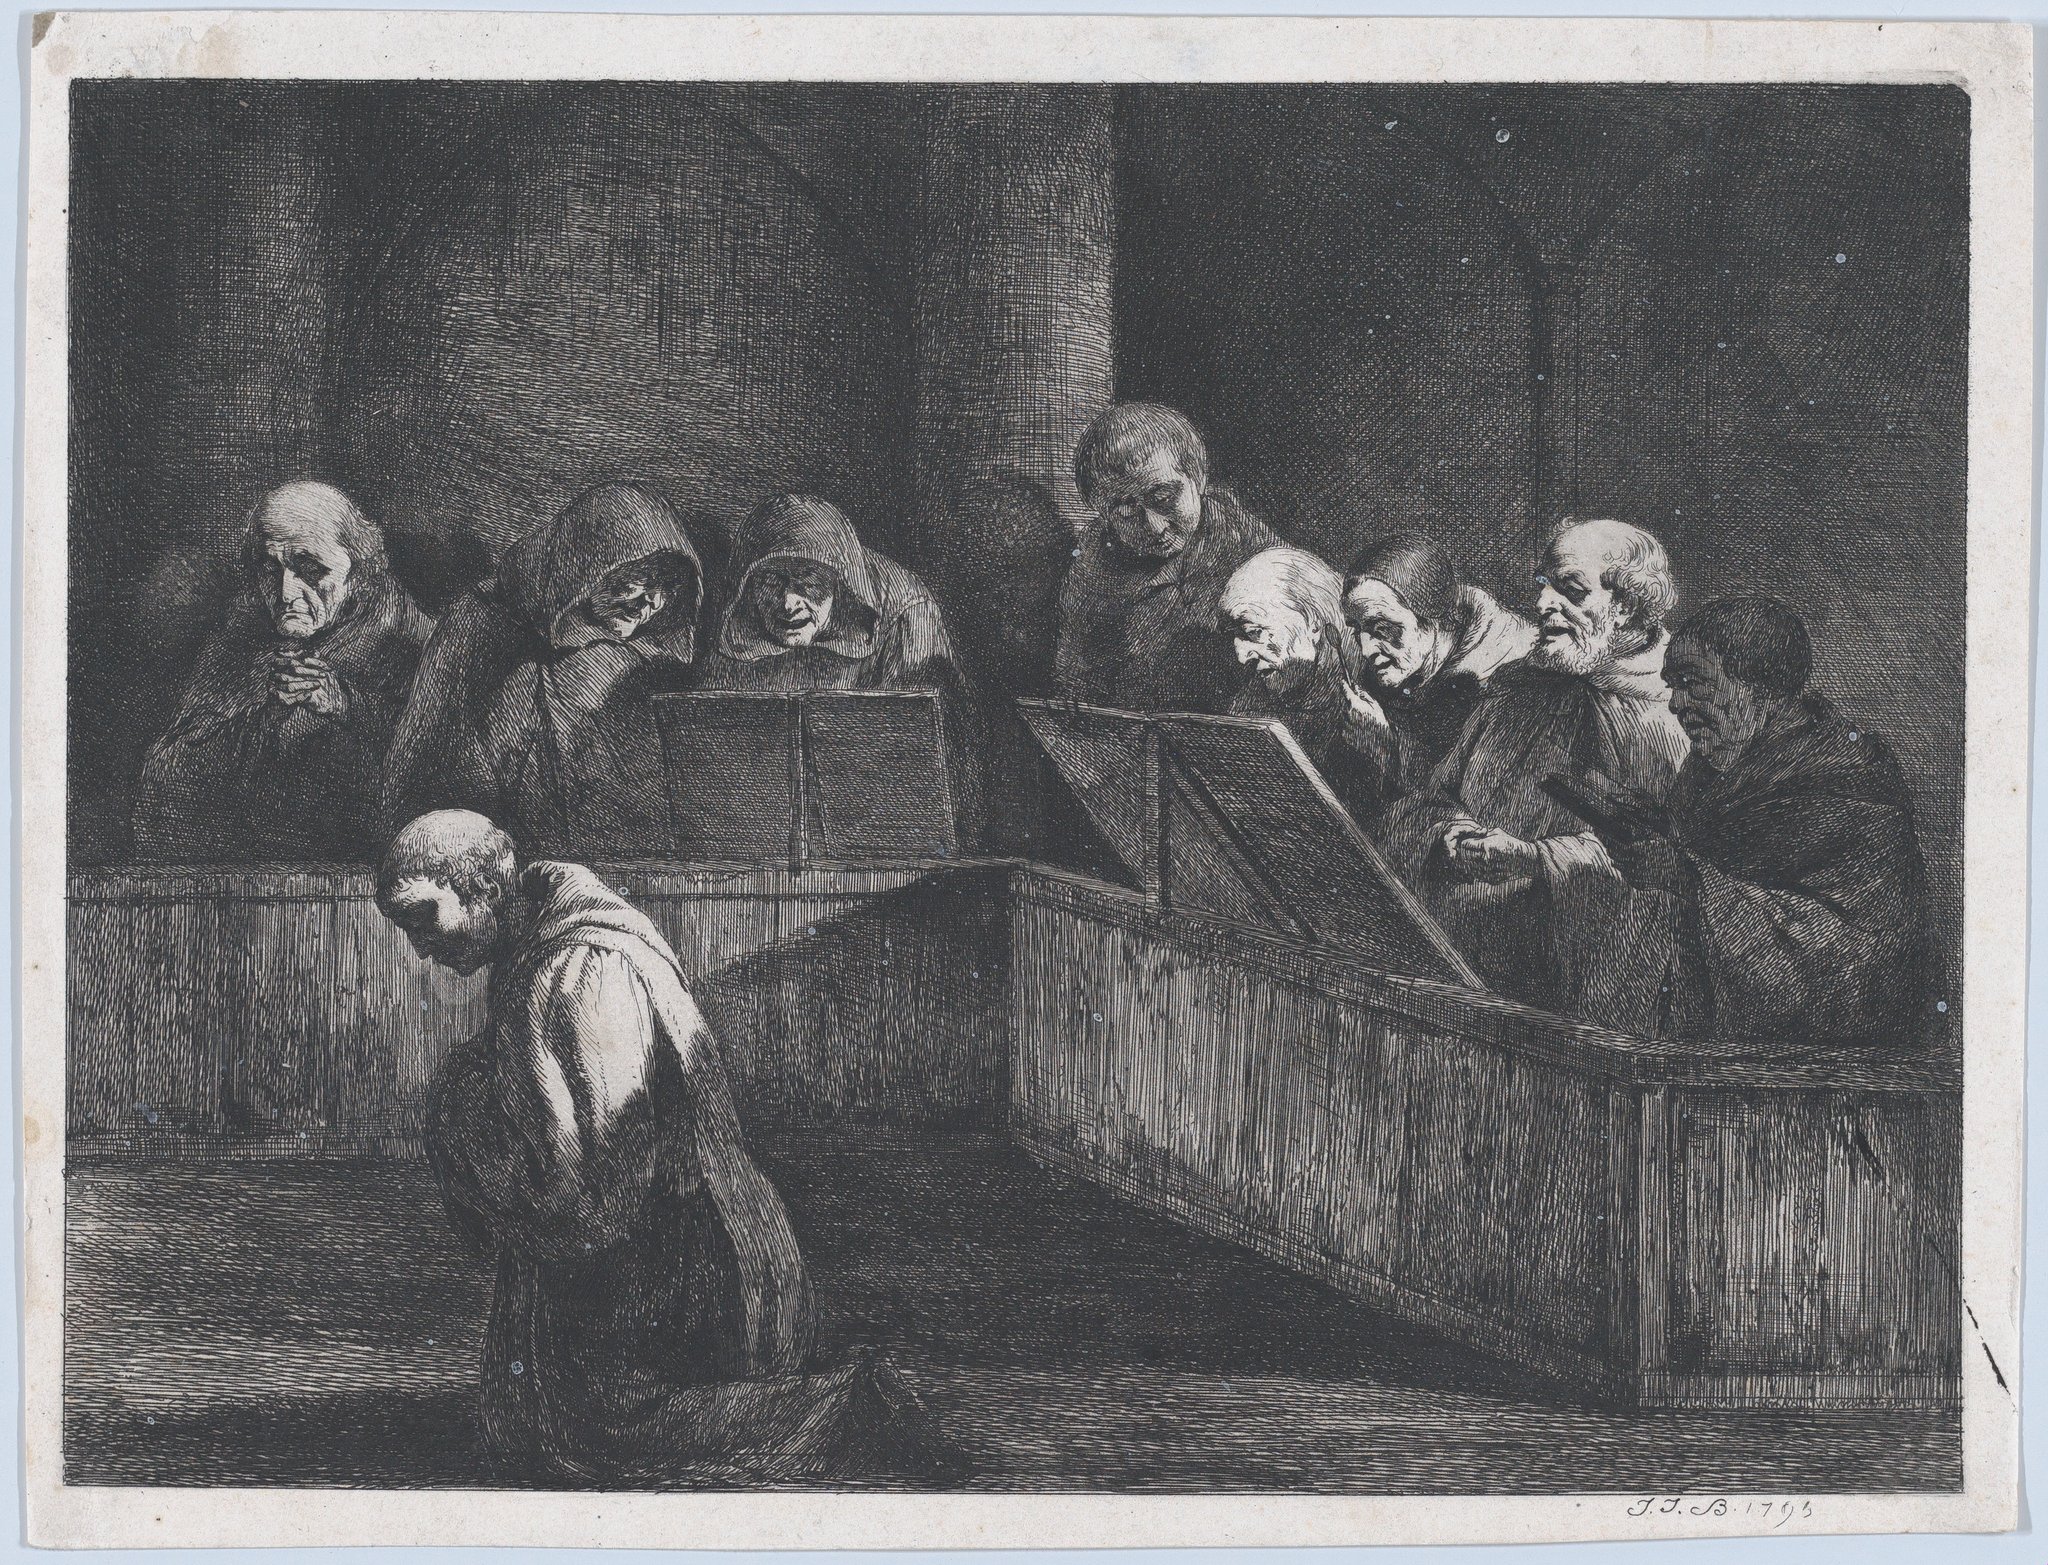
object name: print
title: Monks Chanting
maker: jean jacques de boissieu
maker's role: artist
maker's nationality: french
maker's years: 1736-1810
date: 1795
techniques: drypoint, etching, roulette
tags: reading,monks